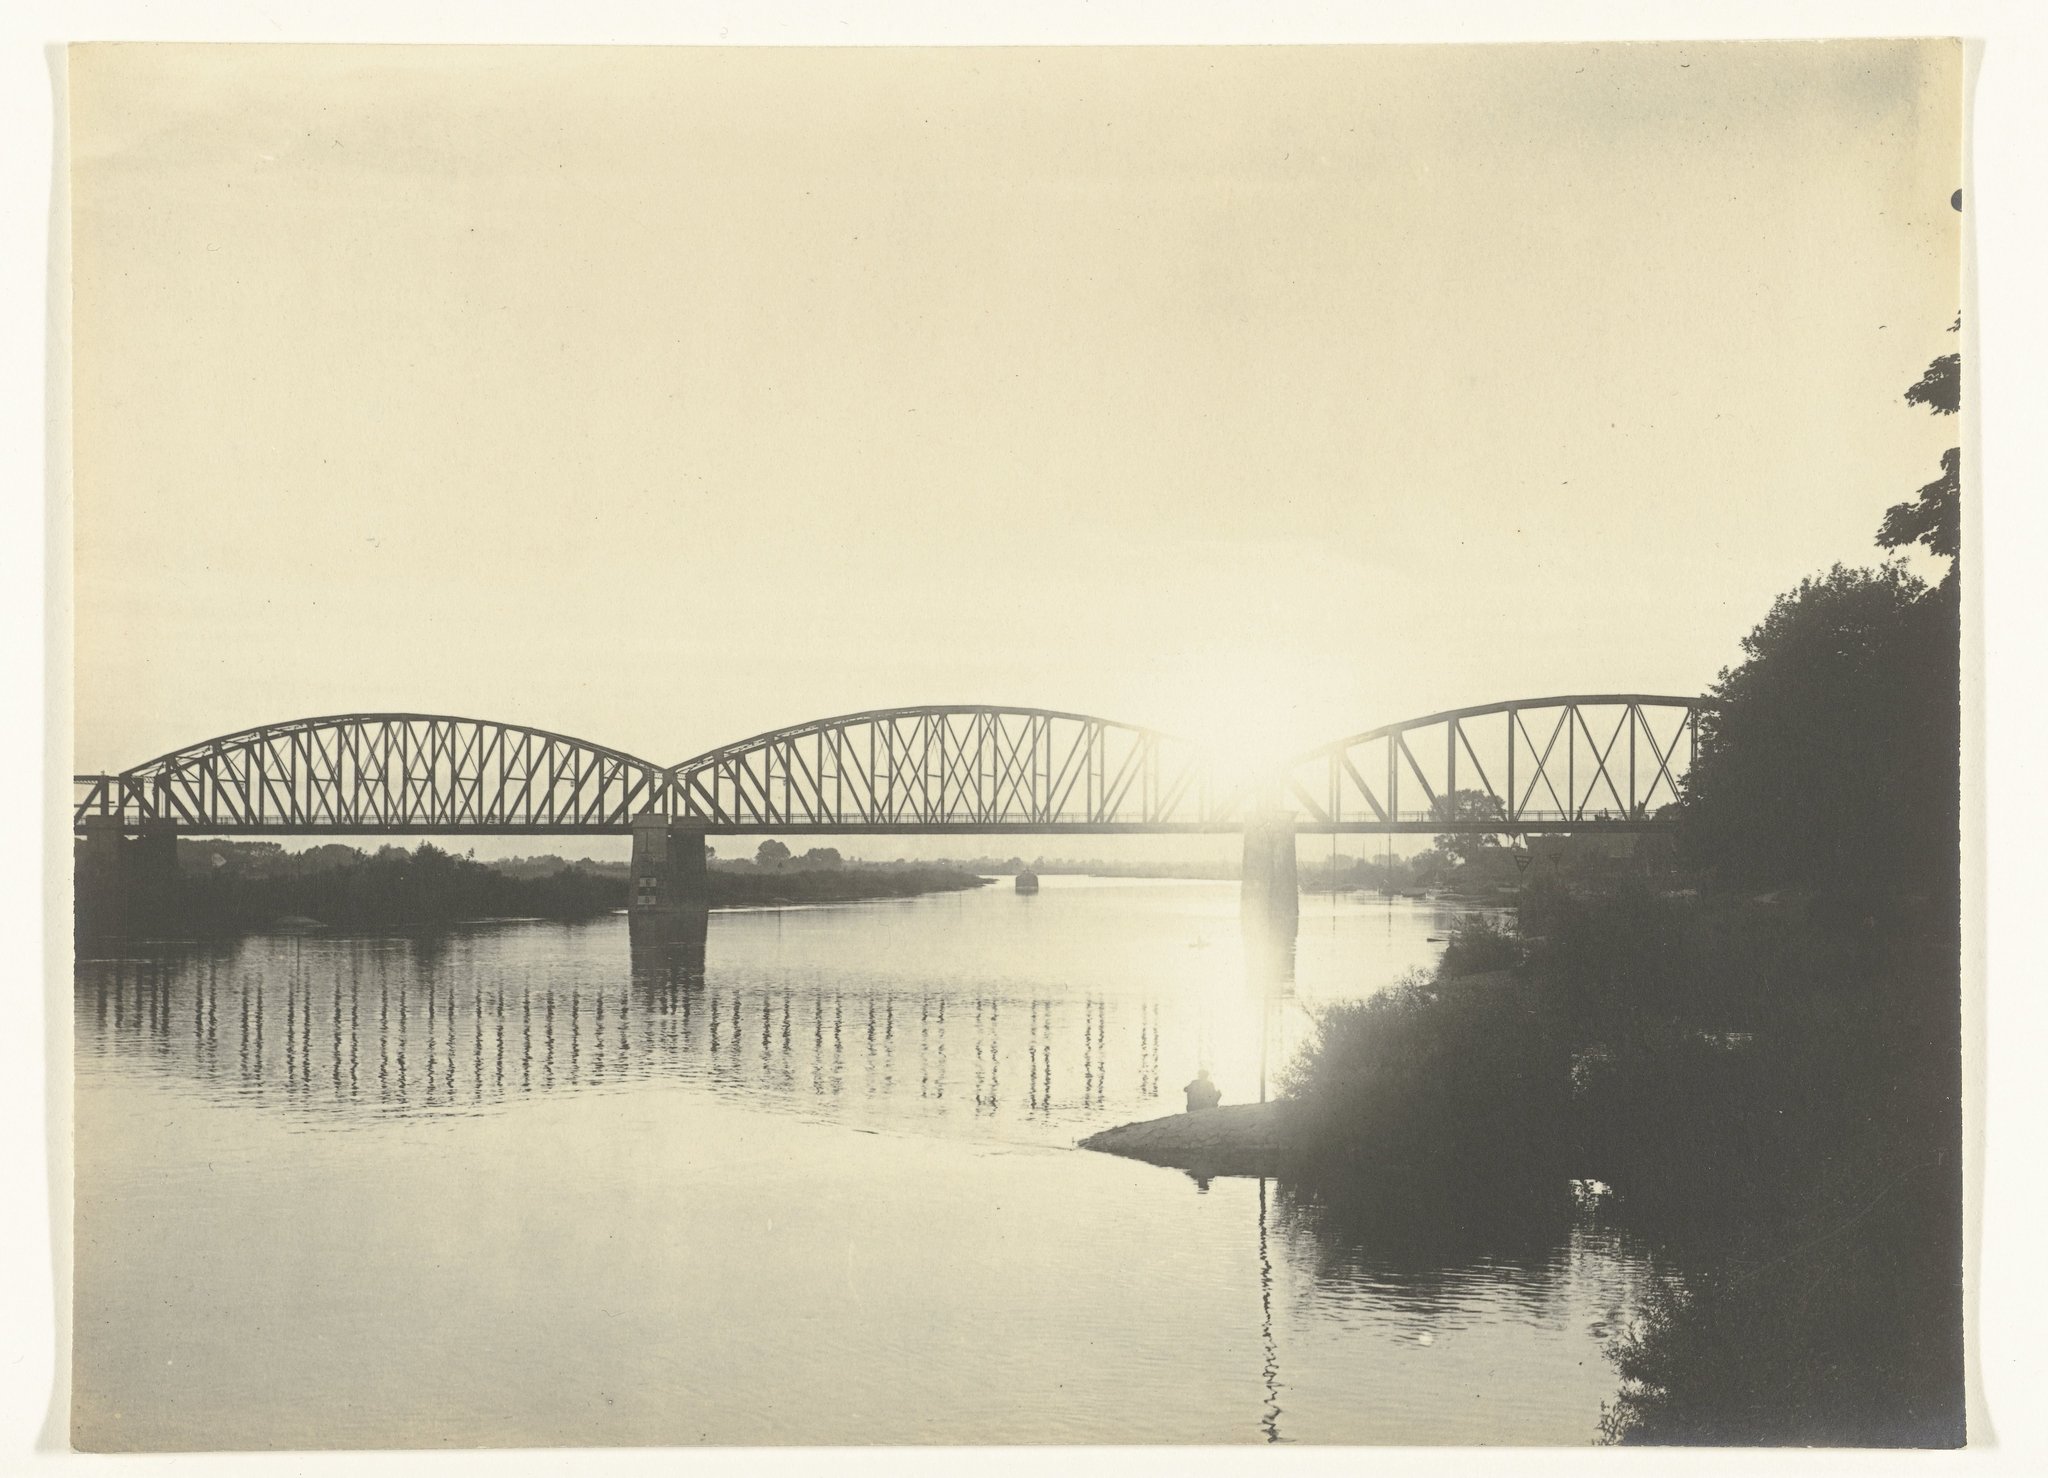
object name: photograph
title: Brug over een rivier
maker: richard tepe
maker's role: fotograaf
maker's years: 1864-1952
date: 1900-1930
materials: photographic support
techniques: gelatin silver print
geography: netherlands